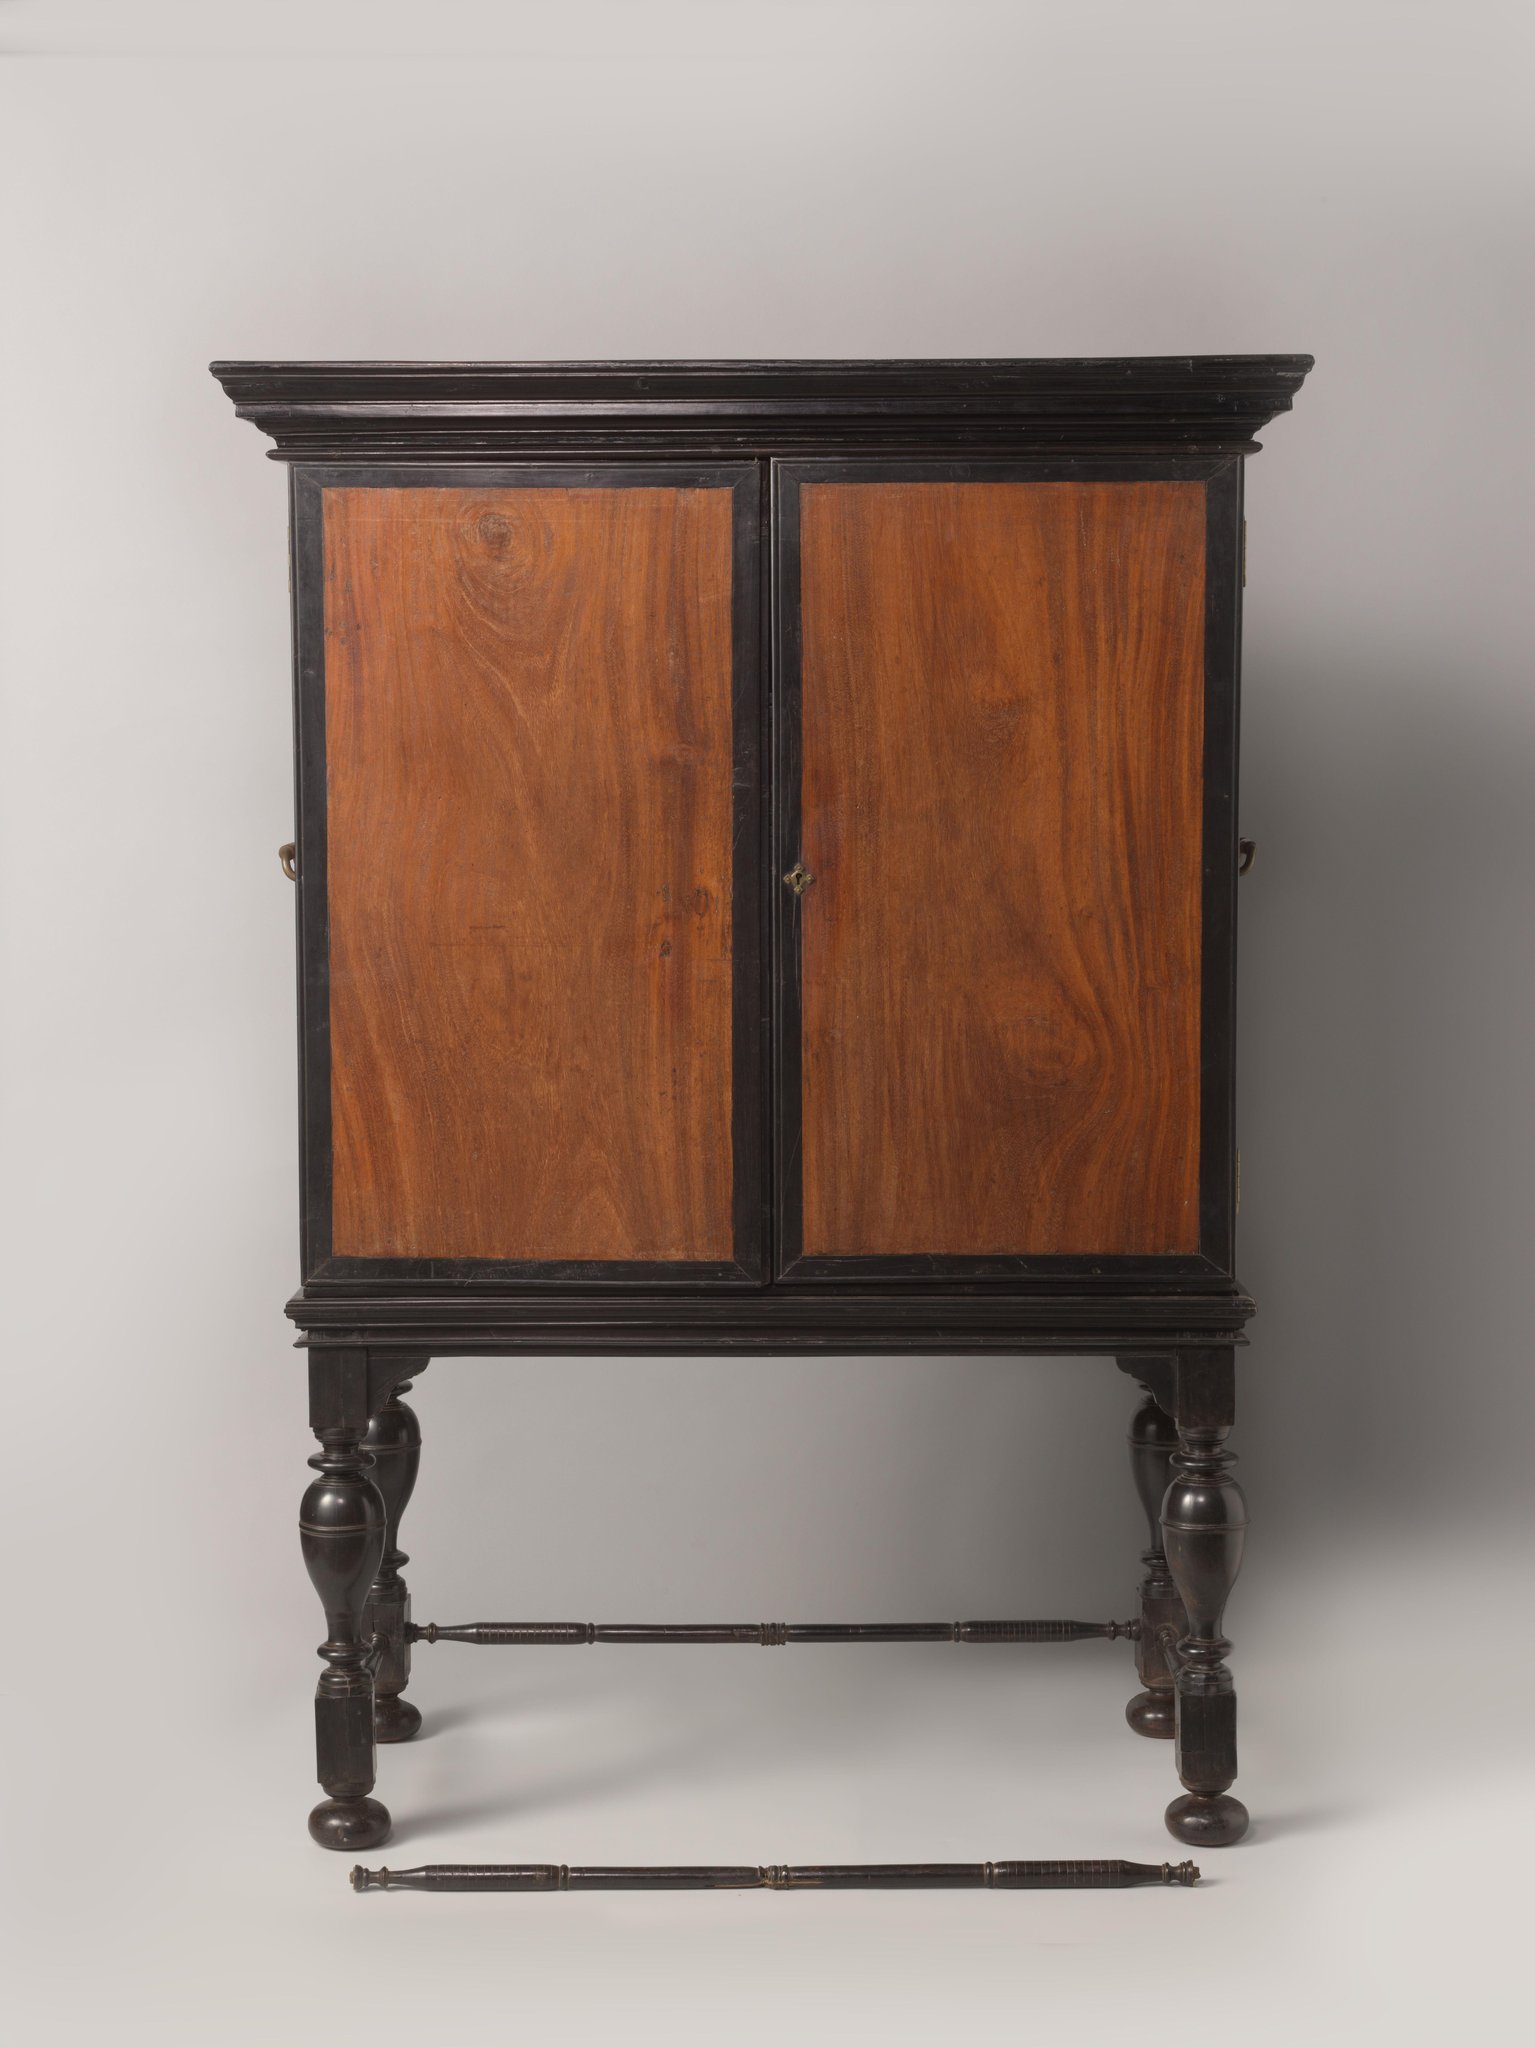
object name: cabinet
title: Kabinet toebehoord hebbende aan Gouverneur Iman Willem Falck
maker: Anonymous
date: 1700-1785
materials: wood, metal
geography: sri lanka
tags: sri lanka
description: Kast van teakhout op een ebbenhouten onderstel. Het onderstel heeft vier vaasvormige gelede poten, bij de huizen onderaan door gelede regels verbonden. Onder de regels zijn accoladevormige hoekstukken aangebracht. Het blad van het onderstel heeft een hoge geprofileerde rand. De bovenkast heeft twee deuren en draagt aan de zijkanten moderne hengsels. De deuren en zijkanten zijn omgeven met ebbenhouten omlijstingen. De kap heeft een geprofileerde ebbenhouten kaplijst. Sleutel nr. 105. Binnenin negen laden; in het midden twee deuren waarachter drie laden. Onder en opzij van de grootste lade twee kleine laden. Achter de drie laden steeds twee andere kleine laden. Boven de laden oorspronkelijk een vakindeling. Aan binnenzijde op etiket: oud bezit gouverneur Falck.